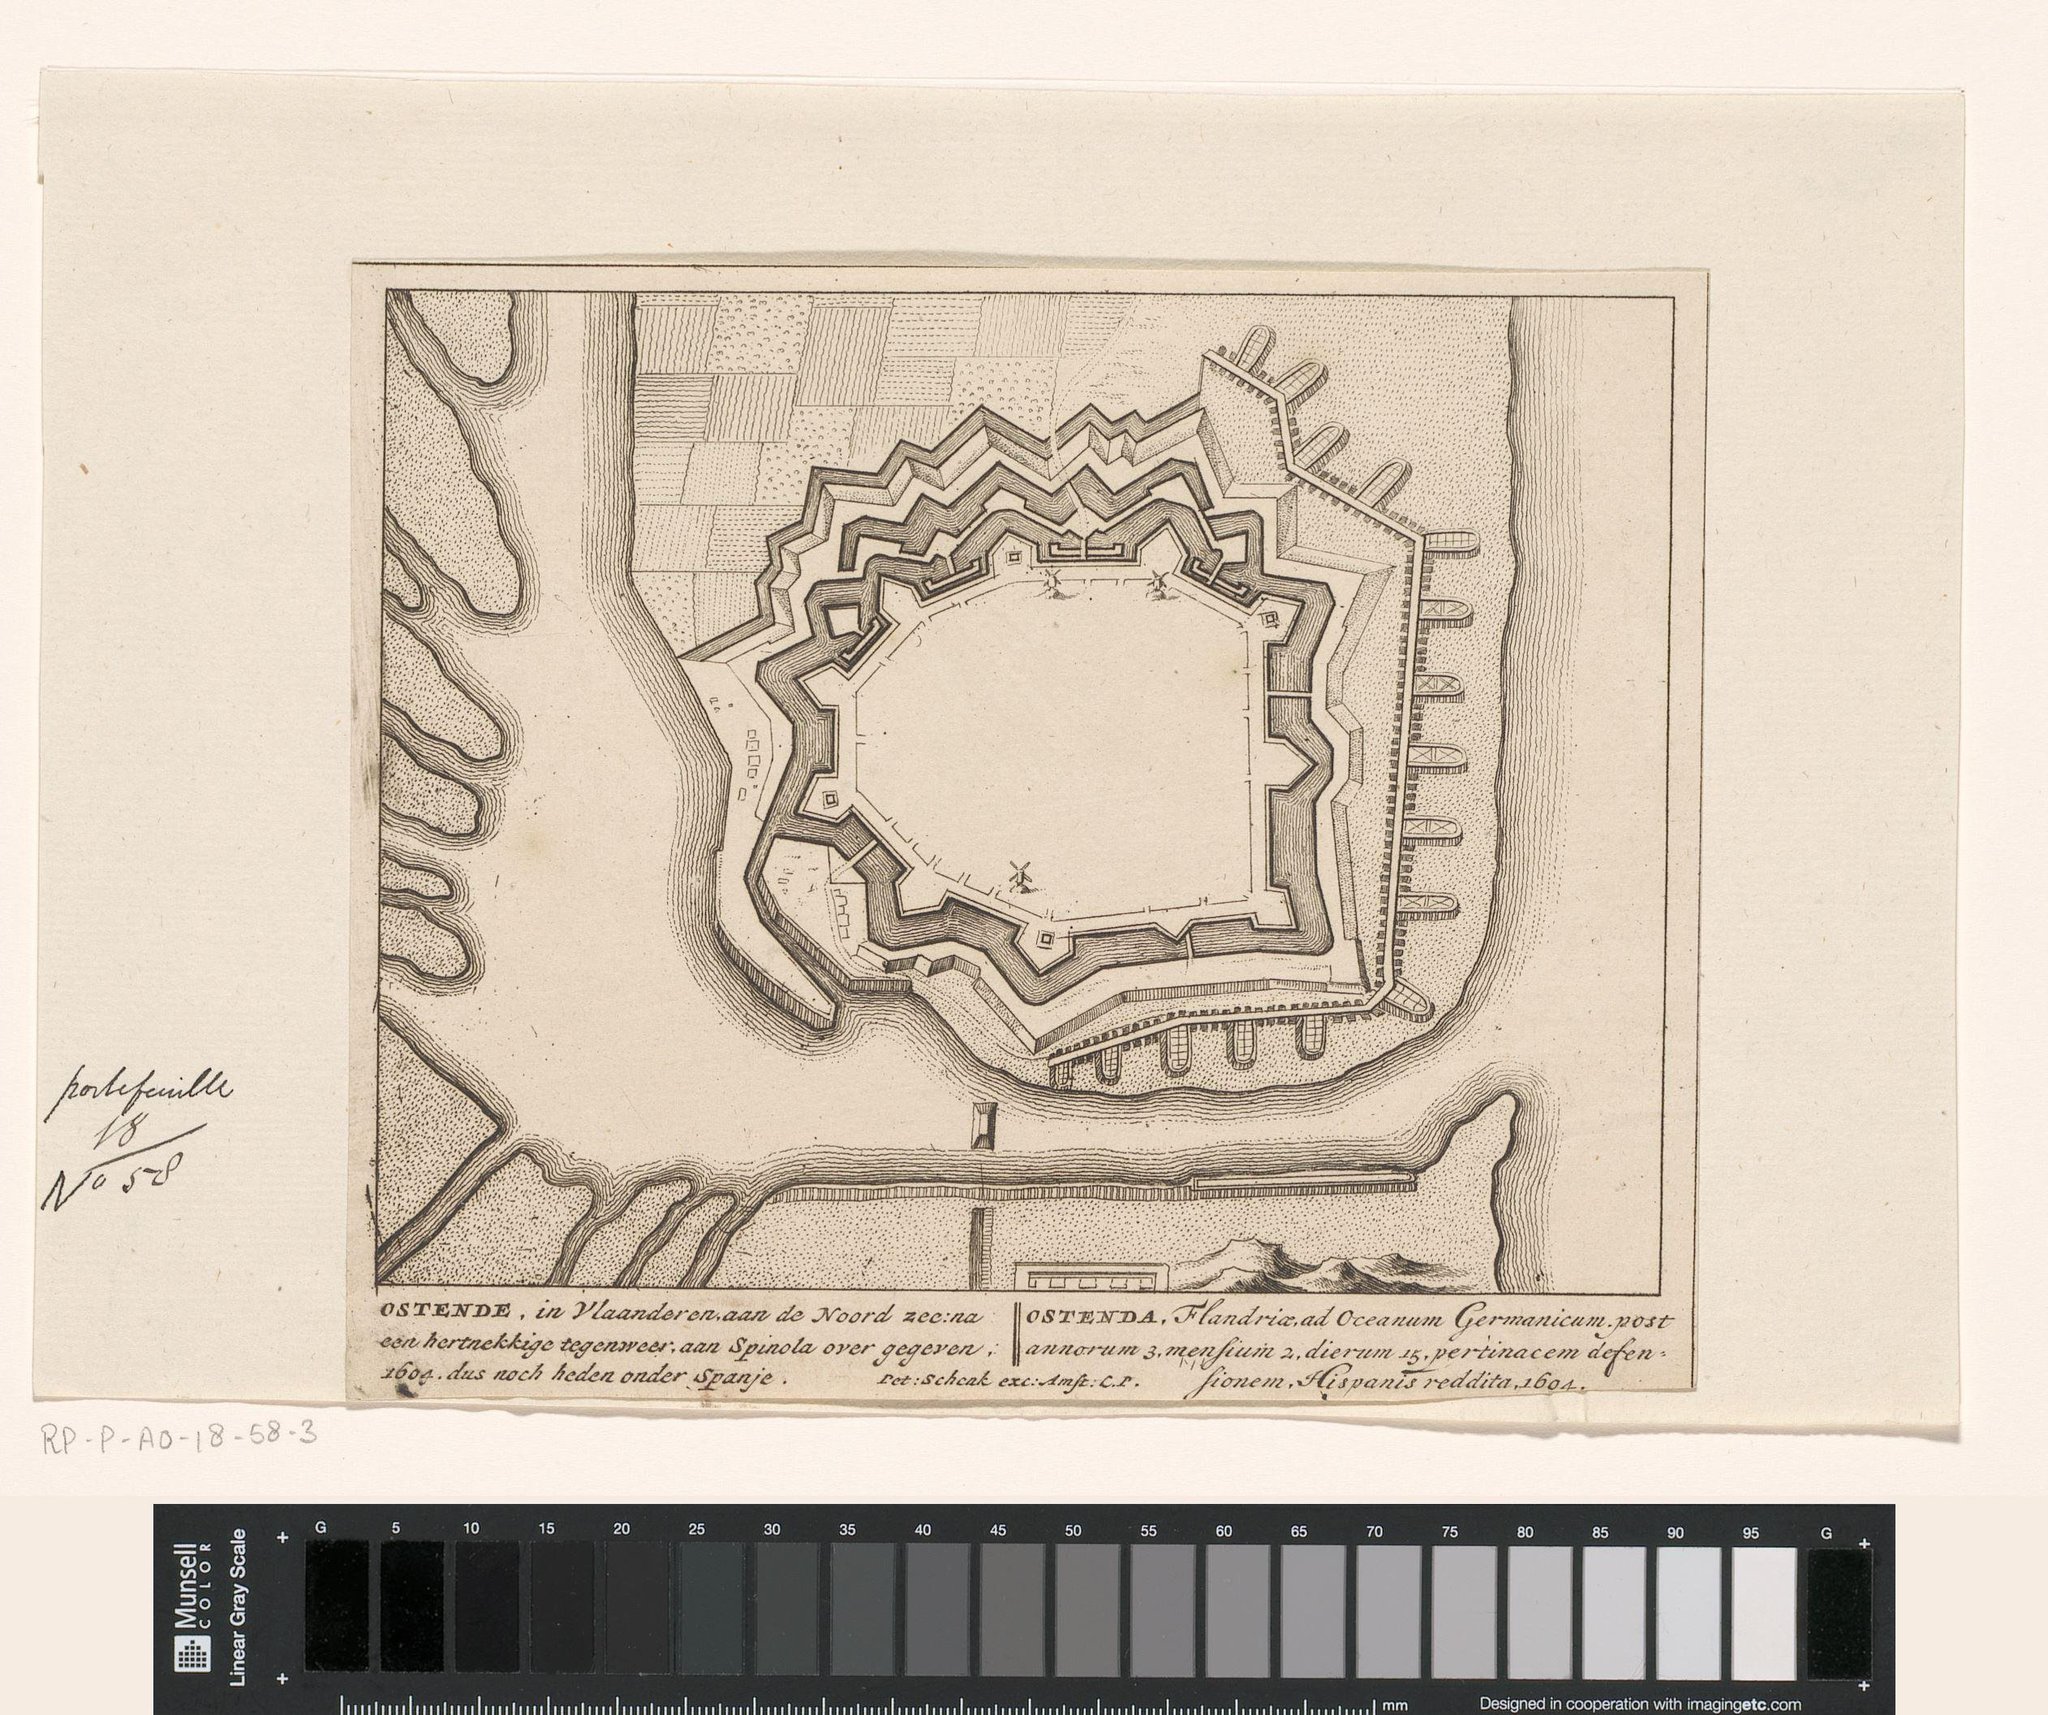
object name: area plan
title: Vestingplattegrond van Oostende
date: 1695-1711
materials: paper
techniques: engraving, etching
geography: amsterdam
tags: fortified city, maps of cities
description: Vestingplattegrond van Oostende. Na het Beleg van Oostende in 1604 door de Spanjaarden veroverd. Onder de voorstelling drieregelige onderschriften in het Nederlands en Latijn.